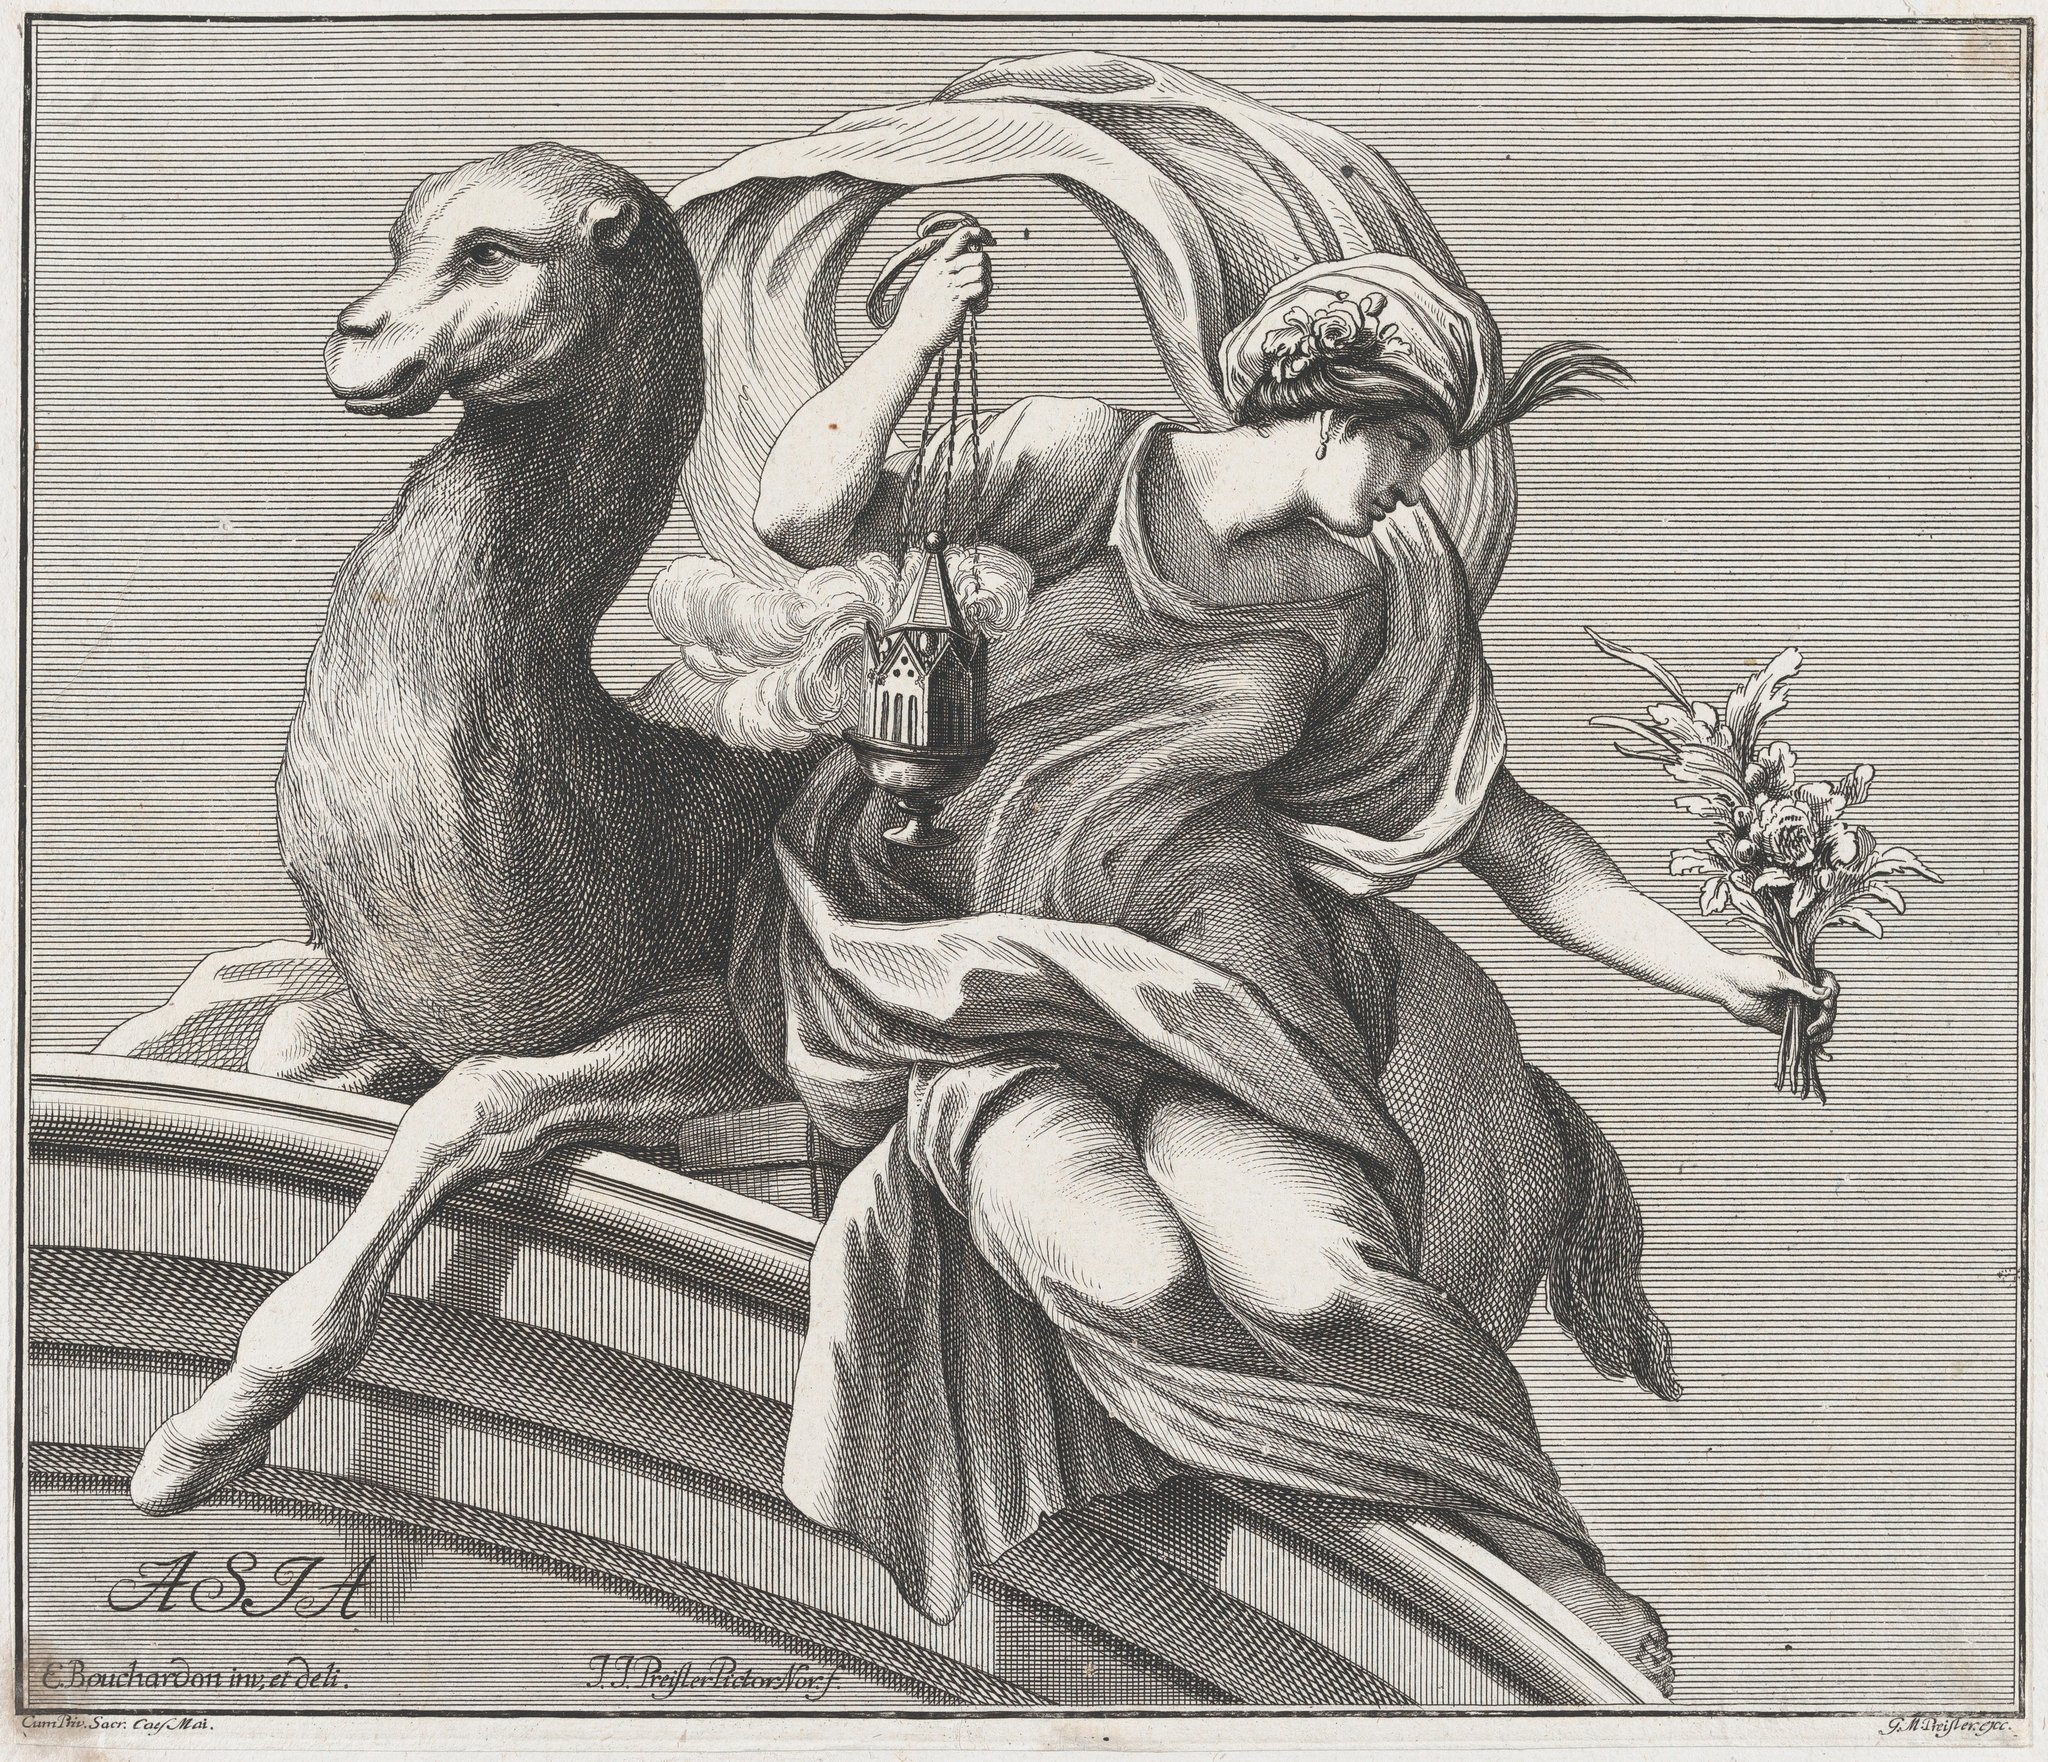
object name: print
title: Allegory of Asia, from "The Four Continents"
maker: johann justin preissler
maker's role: artist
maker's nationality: german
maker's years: 1698-1771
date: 1732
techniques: engraving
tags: women,camels,censers